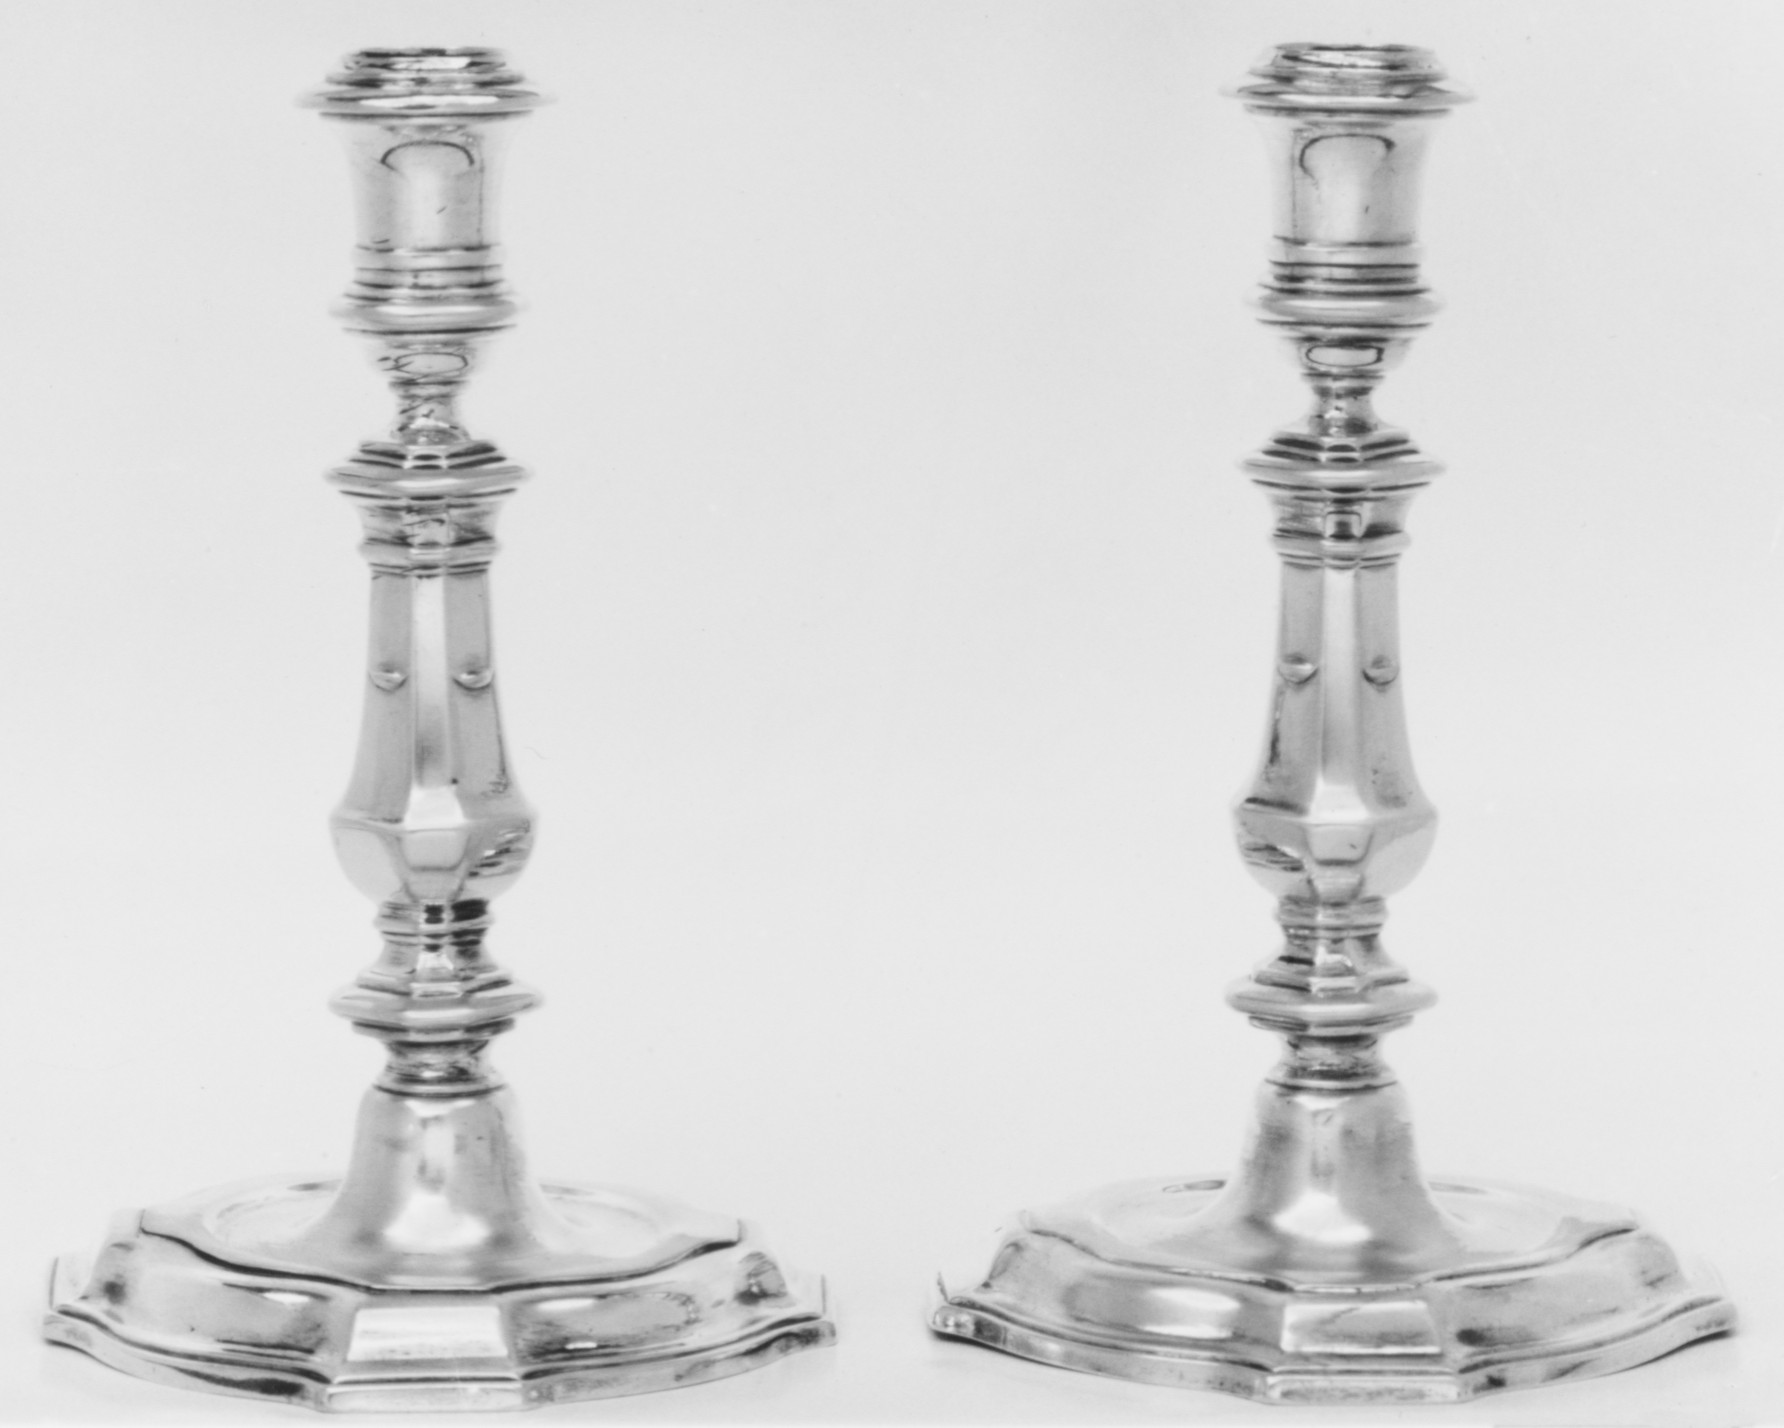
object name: candlestick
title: Candlestick (one of a pair)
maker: anthony de rooy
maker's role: maker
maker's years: 1731-1754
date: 1732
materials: silver